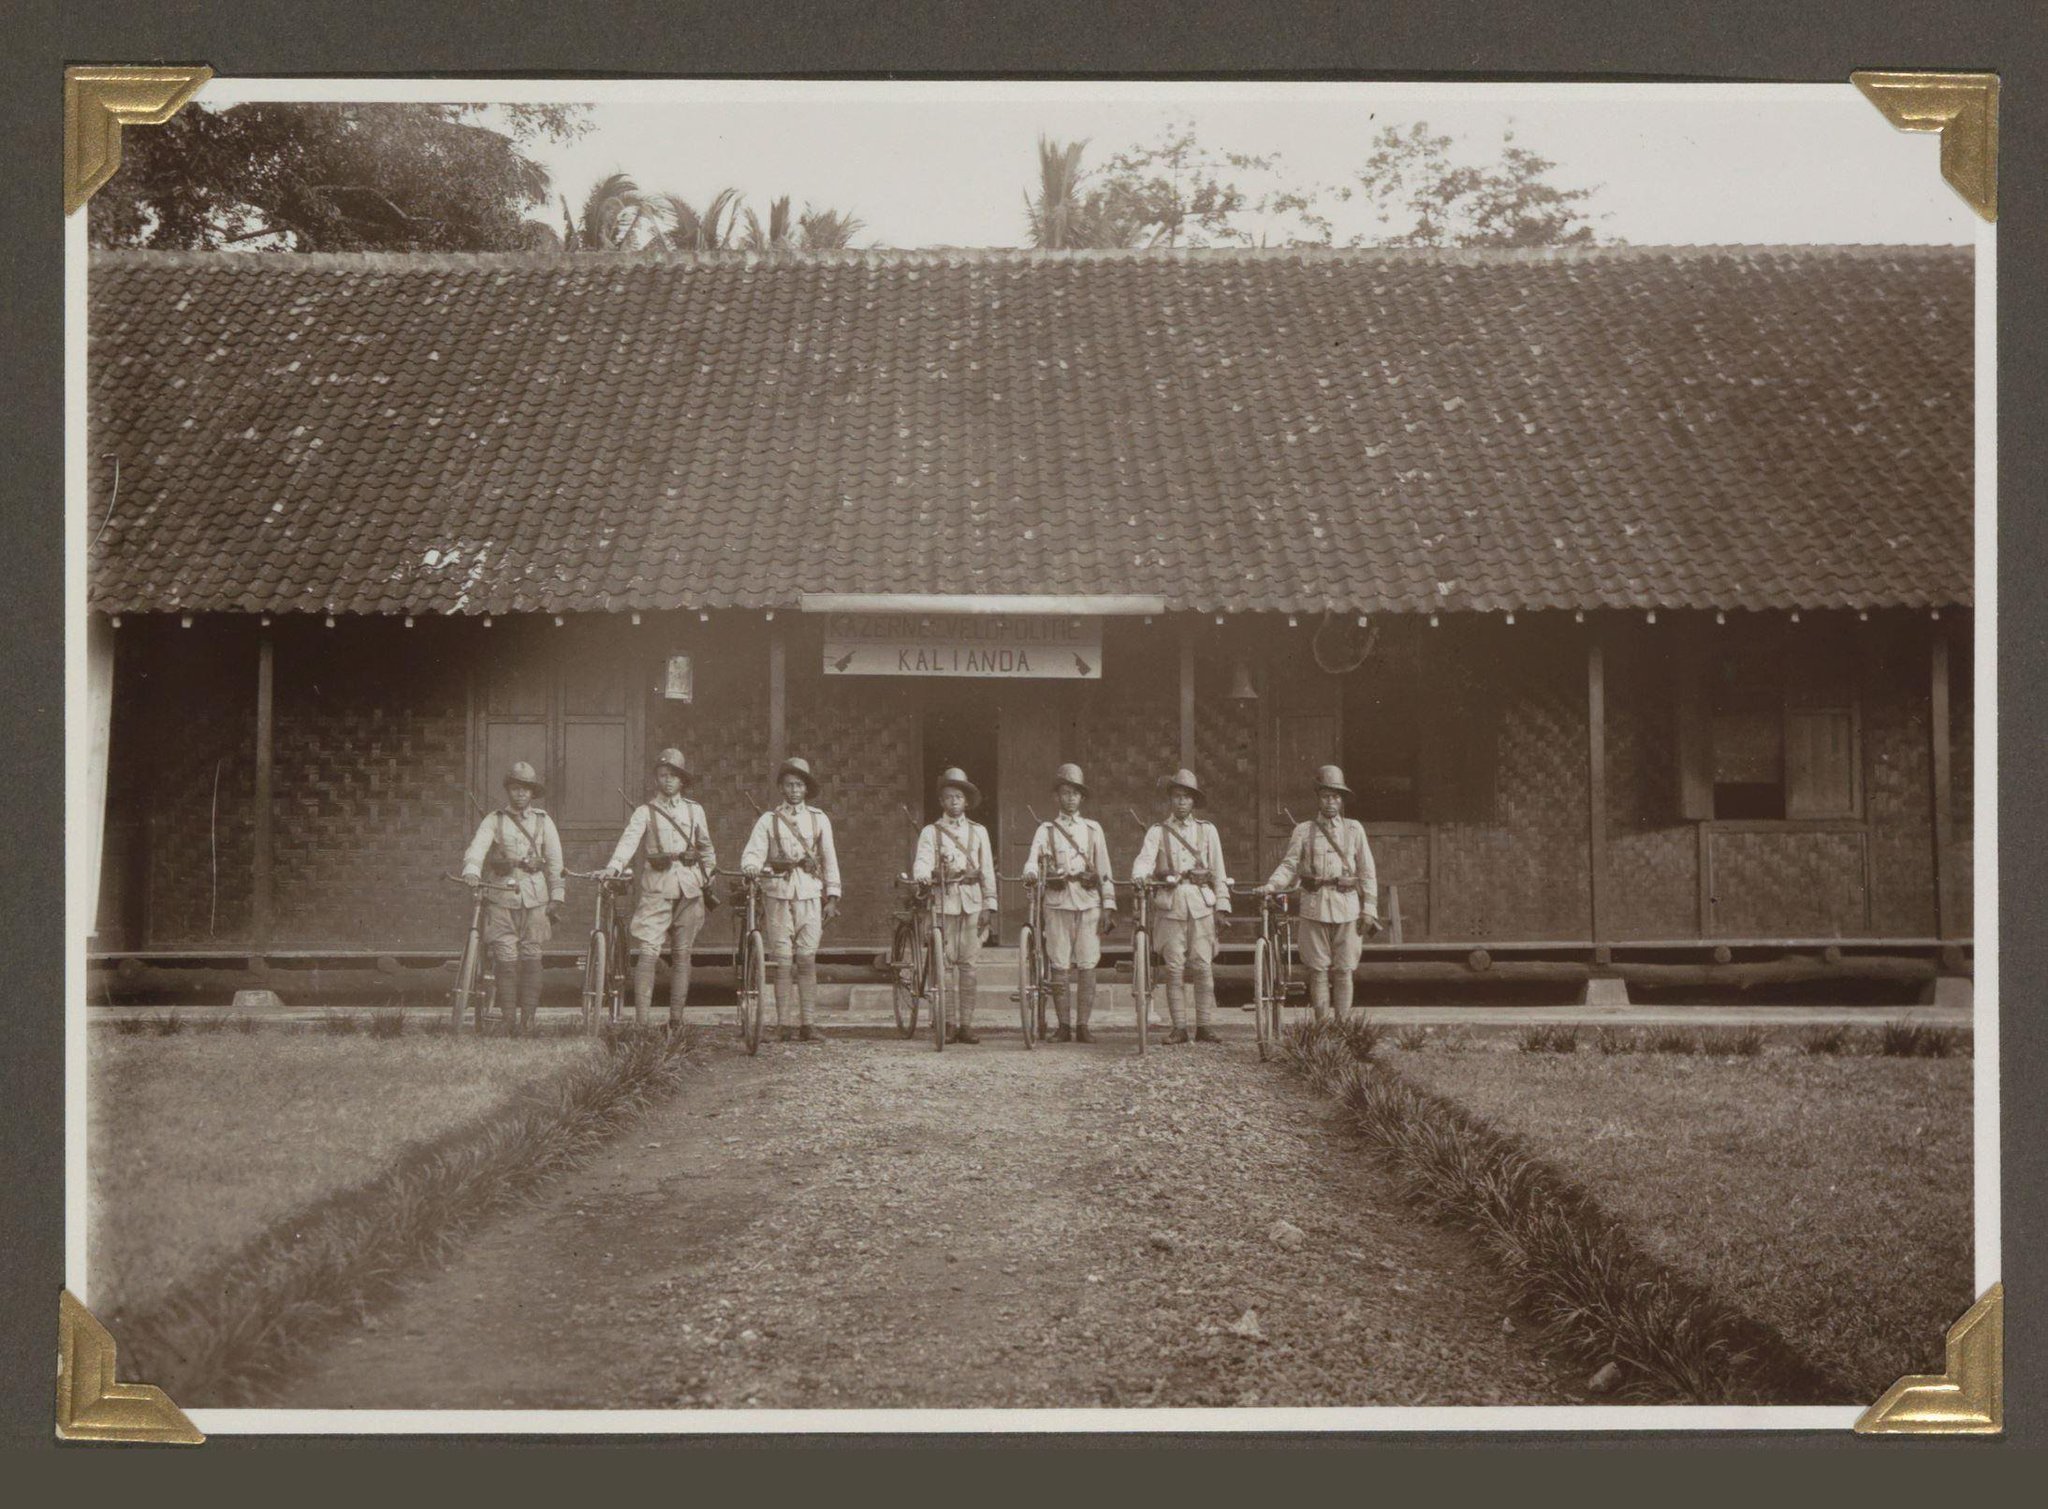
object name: photograph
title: Groepsportret van het onderdetachement 'Kalianda' van de politie in Lampong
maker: Anonymous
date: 1932-1933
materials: photographic support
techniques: gelatin silver print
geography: lampung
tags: motor-cycles and other two-wheeled motor-vehicles, bicycle, police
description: Onderdeel van Herinneringsalbum voor F.J. Junius, vertrekkend resident van Lampong (Zuid-Sumatra).